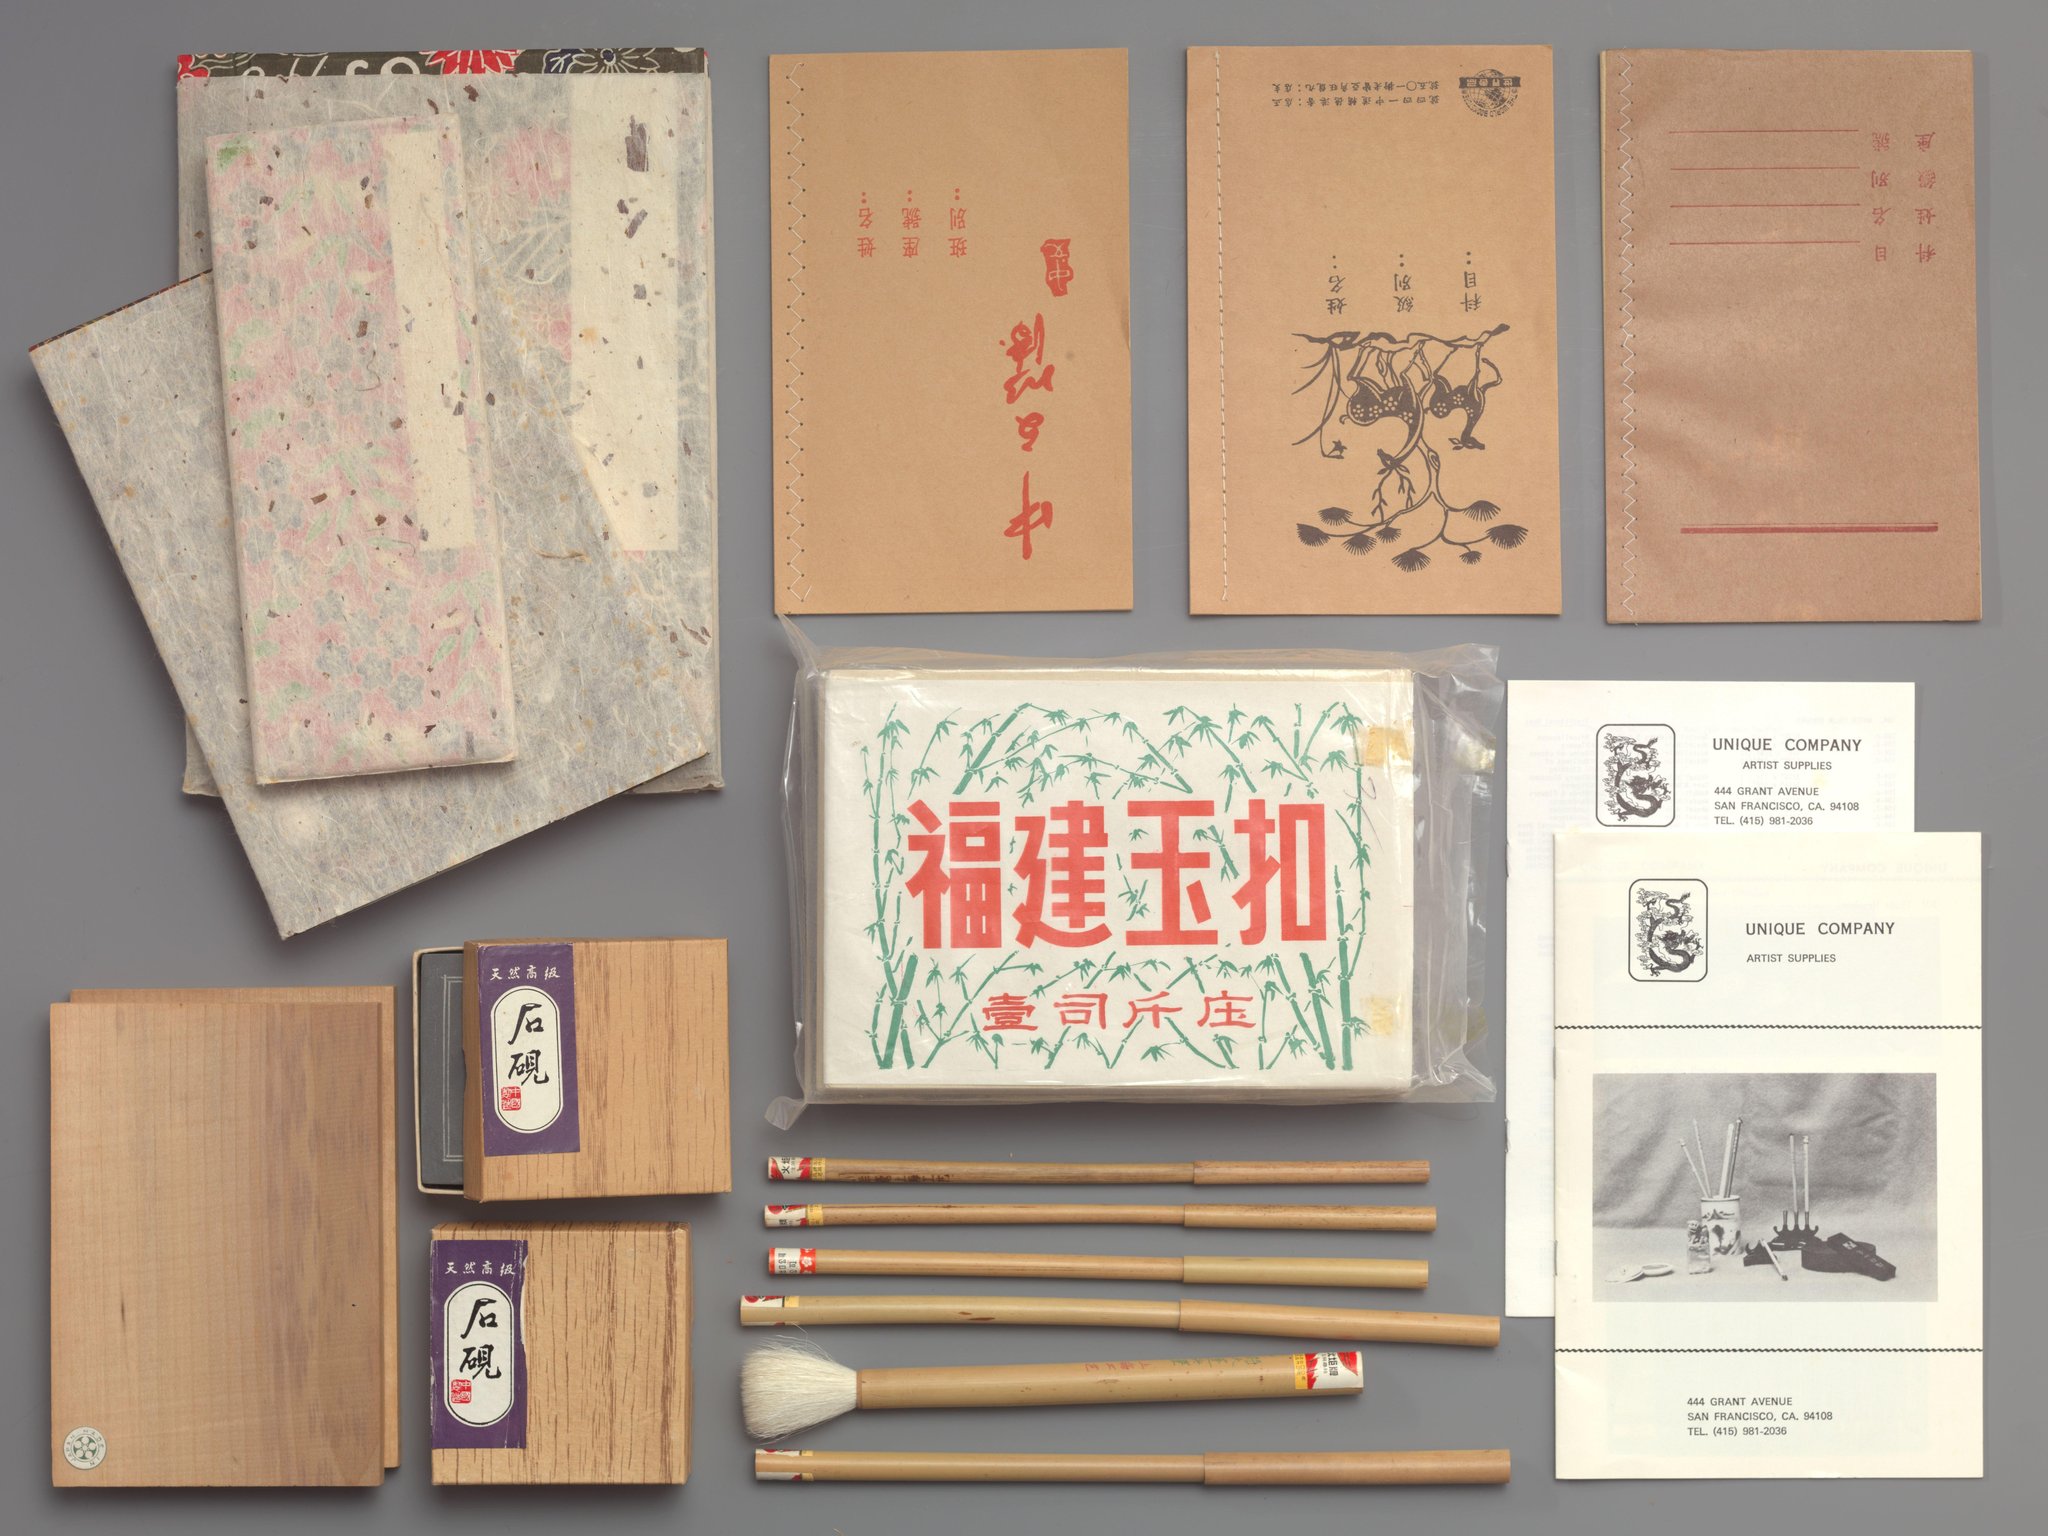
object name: writing instrument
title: Chinees schrijf- en tekengerei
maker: Anonymous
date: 1900-1999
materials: ink, paper, wood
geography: china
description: Onder andere plankjes, inktblokjes, penseel, schetsboeken en losbladig papier.